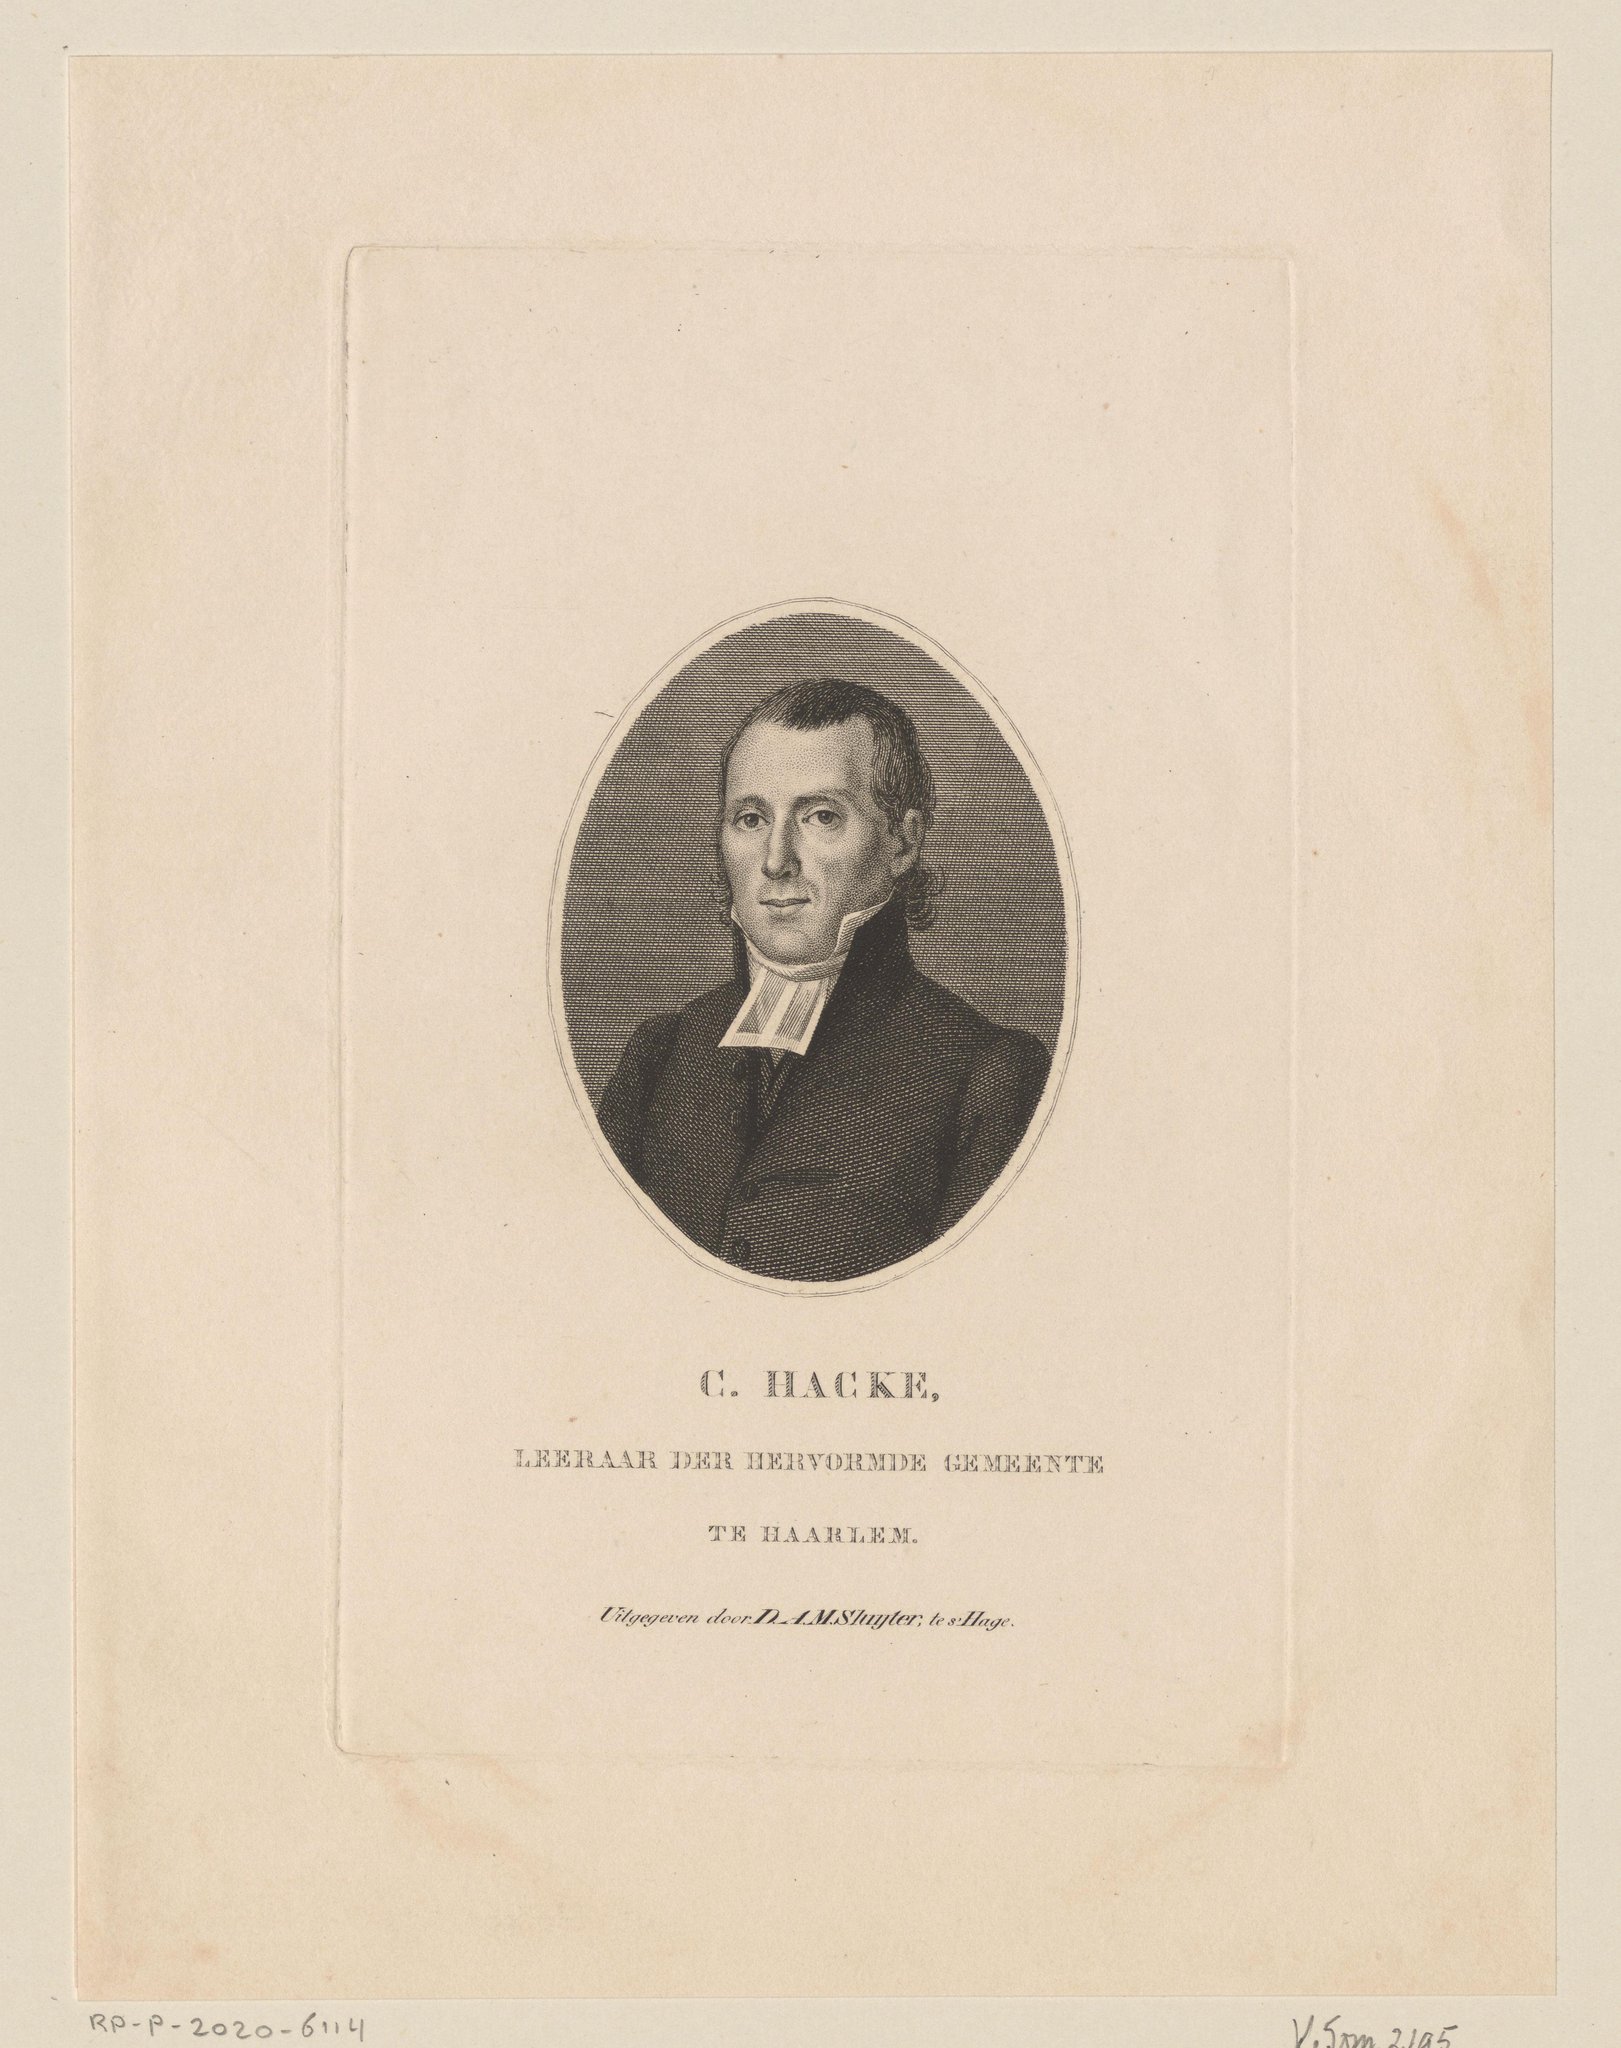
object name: print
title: Portret van Conrad Hacke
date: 1820-1831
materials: paper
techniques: engraving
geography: the hague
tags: historical persons